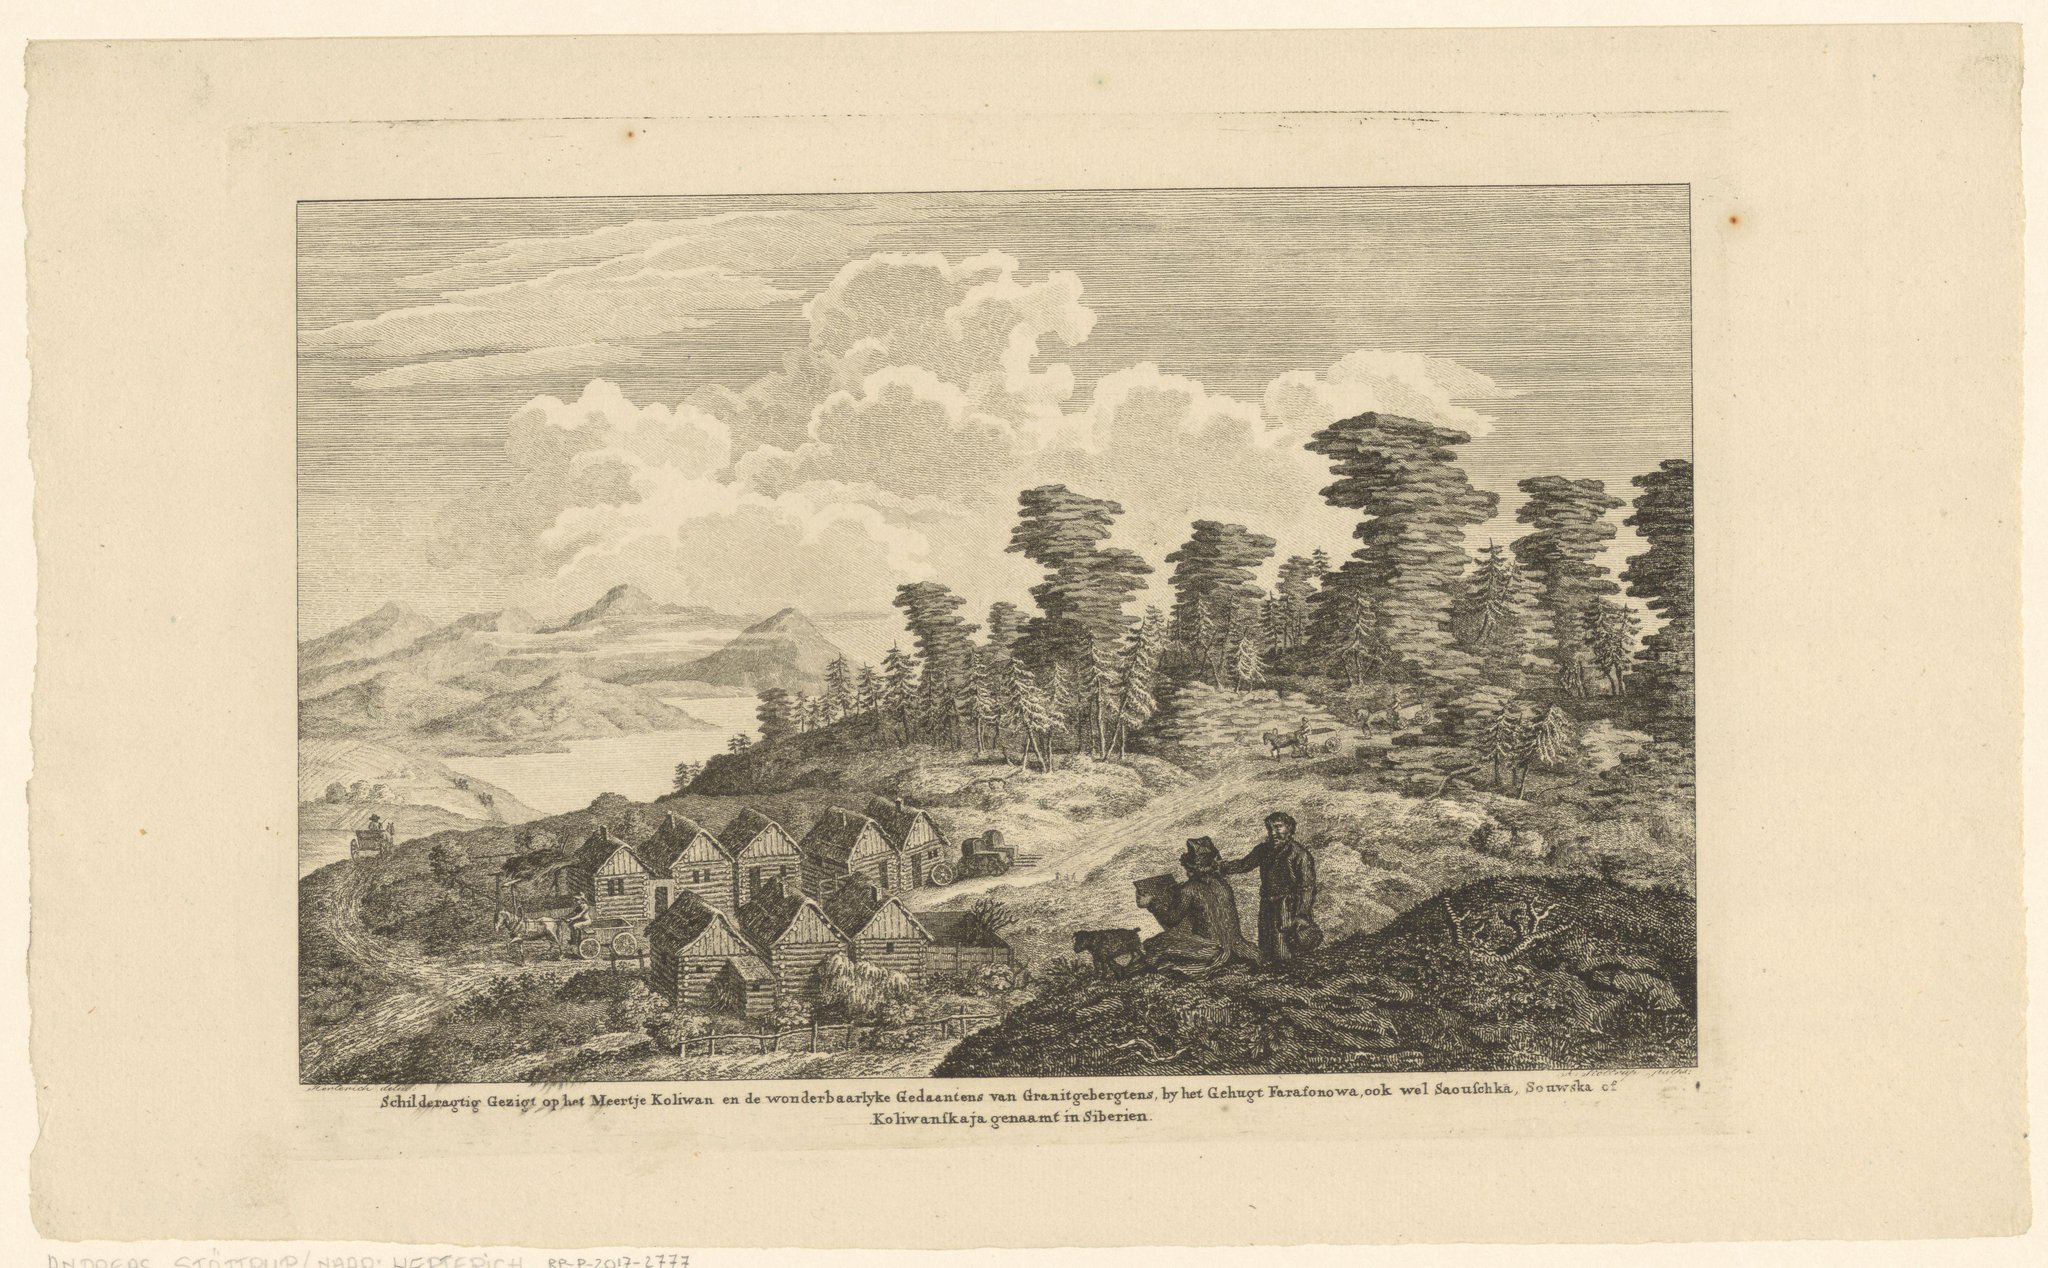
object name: print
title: Schilderagtig Gezigt op het Meertje Koliwan en de wonderbaarlyke Gedaantens van Granitgebergtes, by het Gehugt Farafonowa, ook wel Saouschka, Souwka of Koliwanskaja genaamt in Siberien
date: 1782-1812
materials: paper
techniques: etching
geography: hamburg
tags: lake, draughtsman at work - cc - out of doors, landscapes (+ landscape with figures, staffage), mountains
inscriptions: collector's mark: Lugt 2228